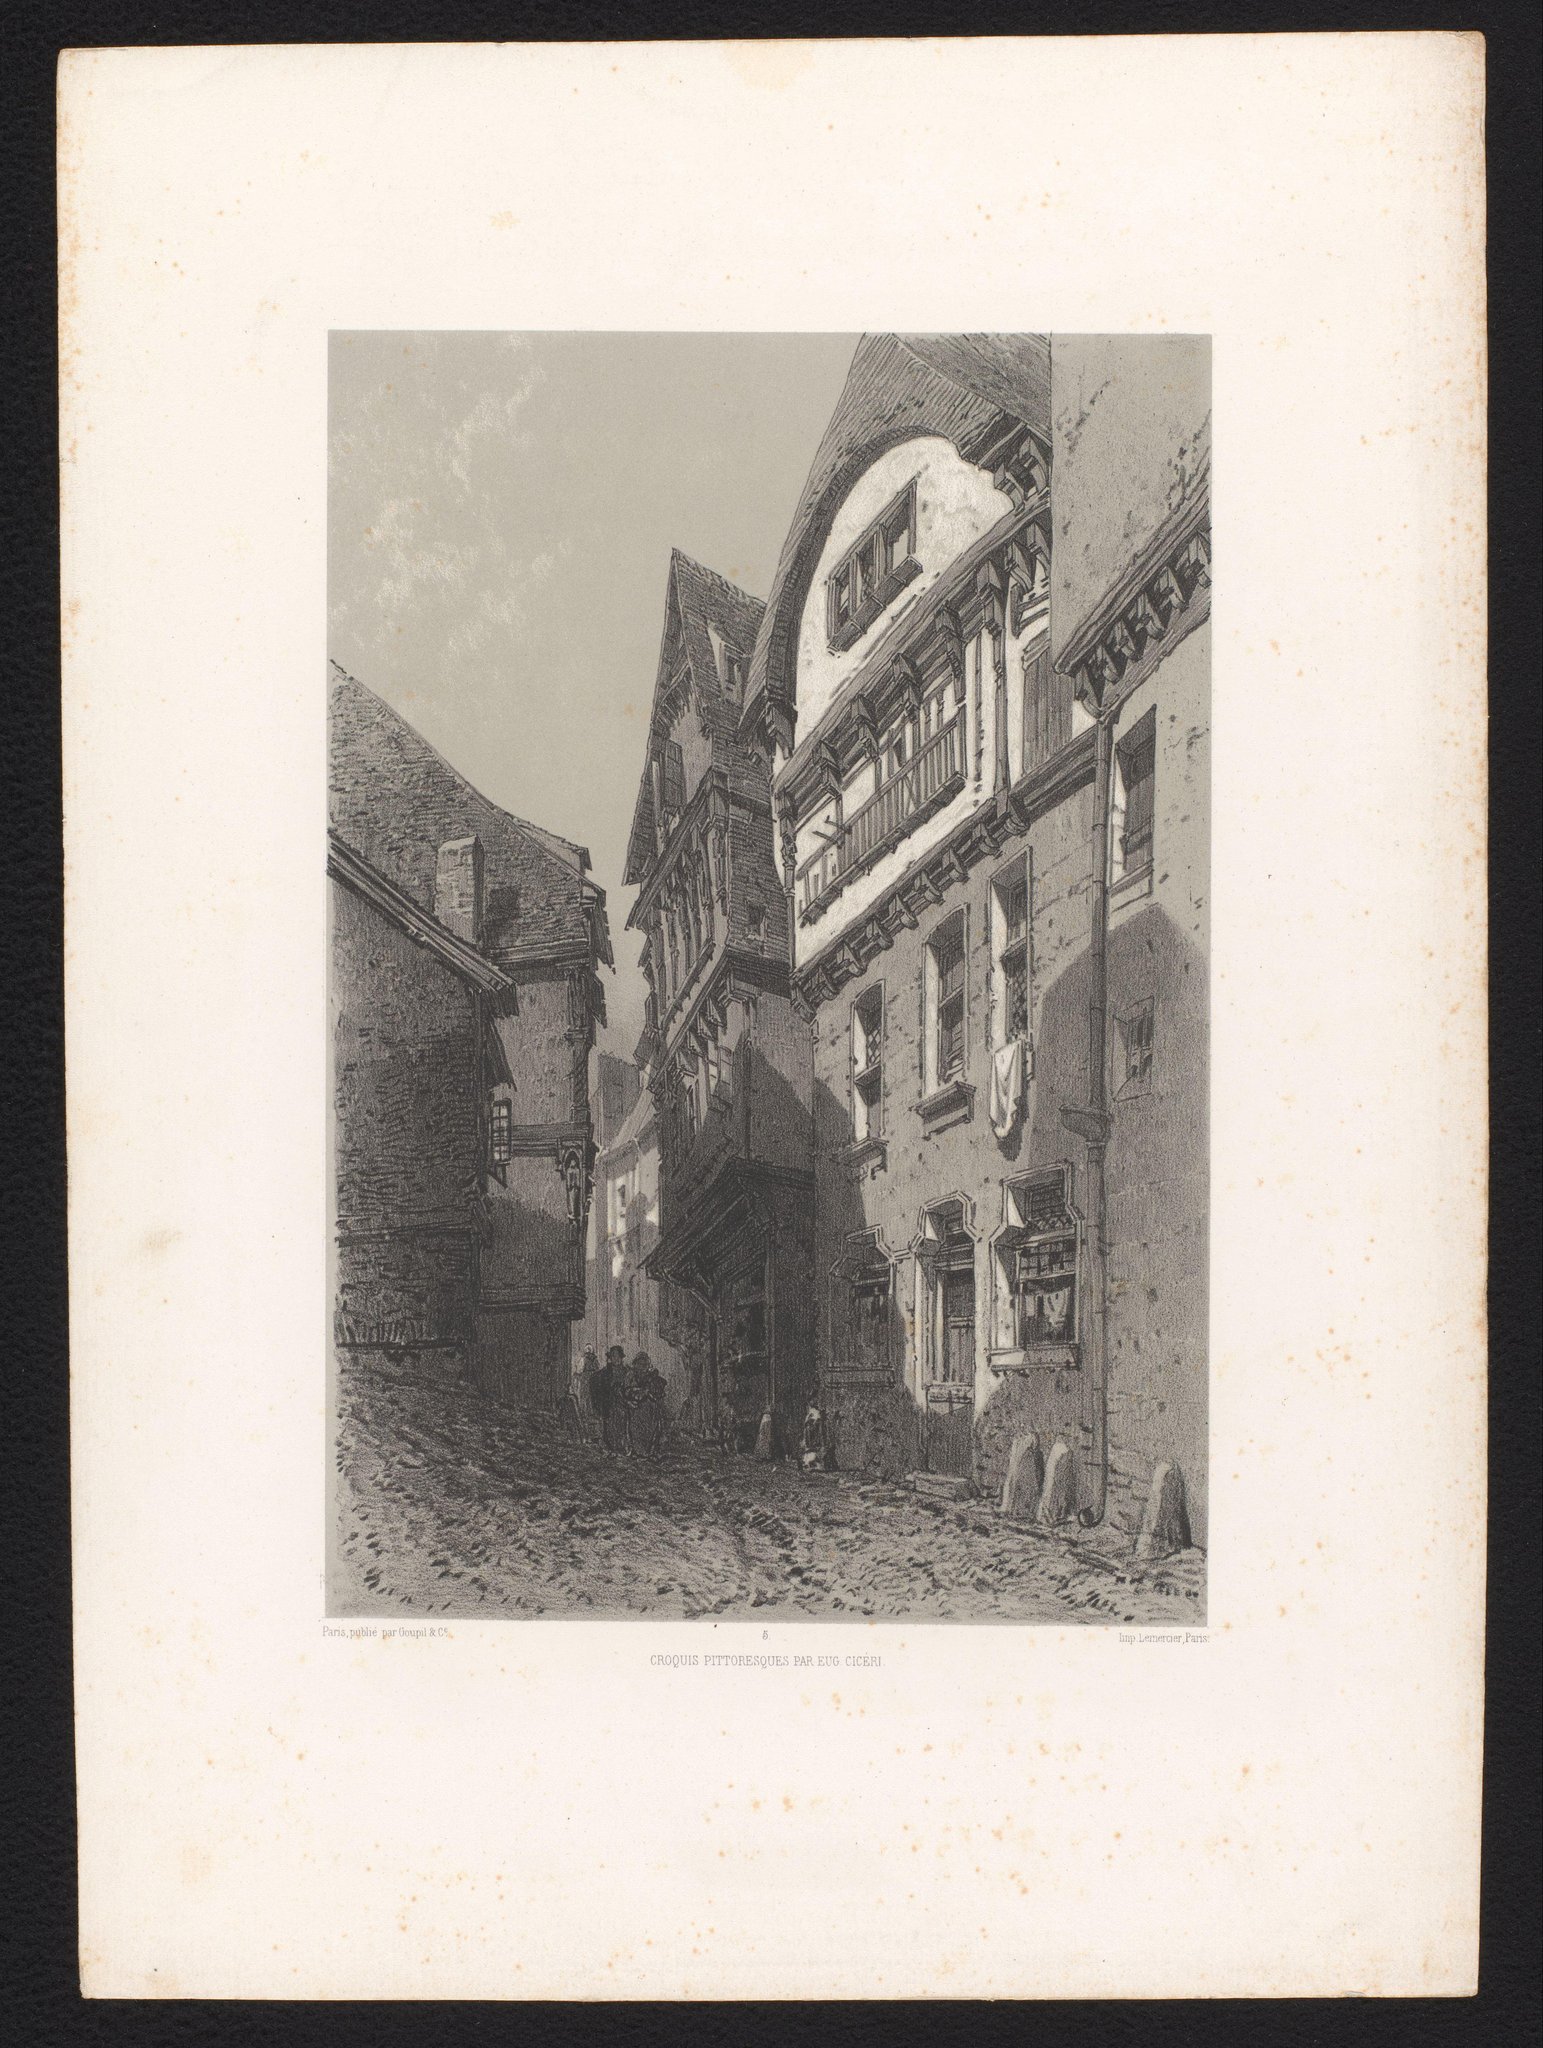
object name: print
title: Steeg met huizen in de avondschemering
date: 1854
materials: paper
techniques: tone lithography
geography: paris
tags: urban housing, dusk, evening twilight, street (+ city(-scape) with figures, staffage)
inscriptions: check stamp: Lugt 1090